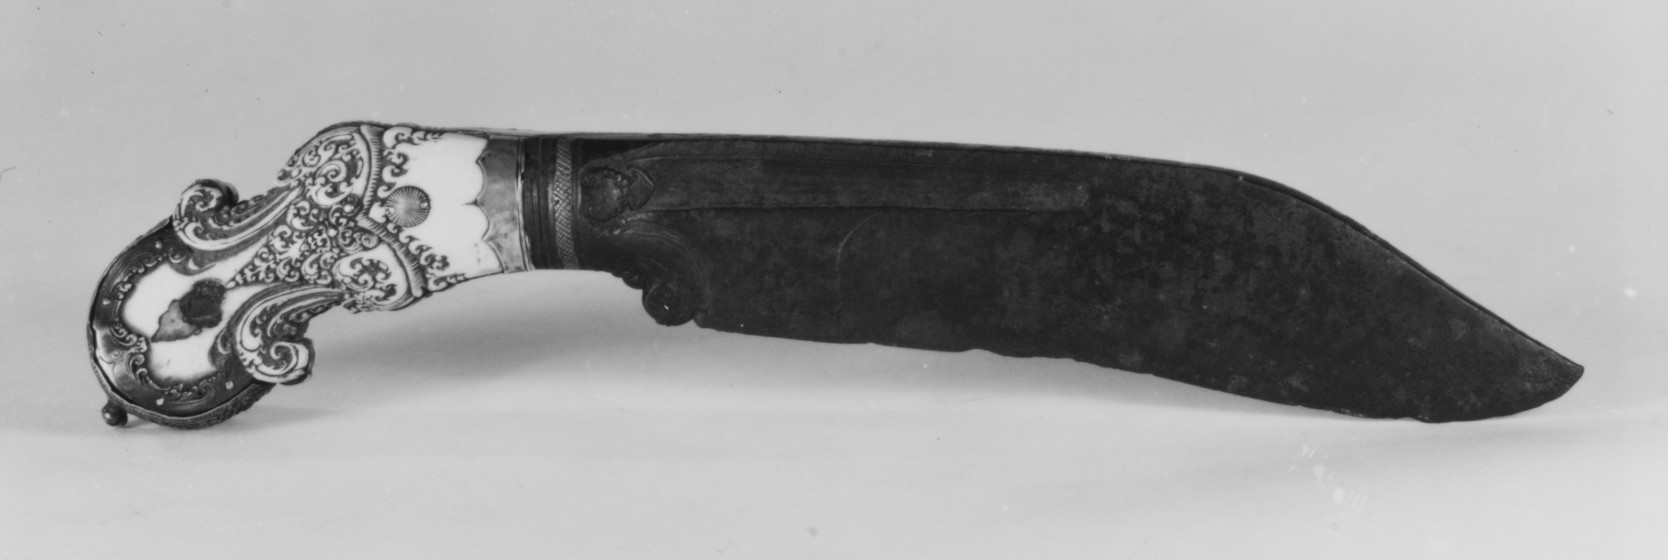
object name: knife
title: Knife, Kandyan Type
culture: sri lankan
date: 1701-1800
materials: ivory, silver